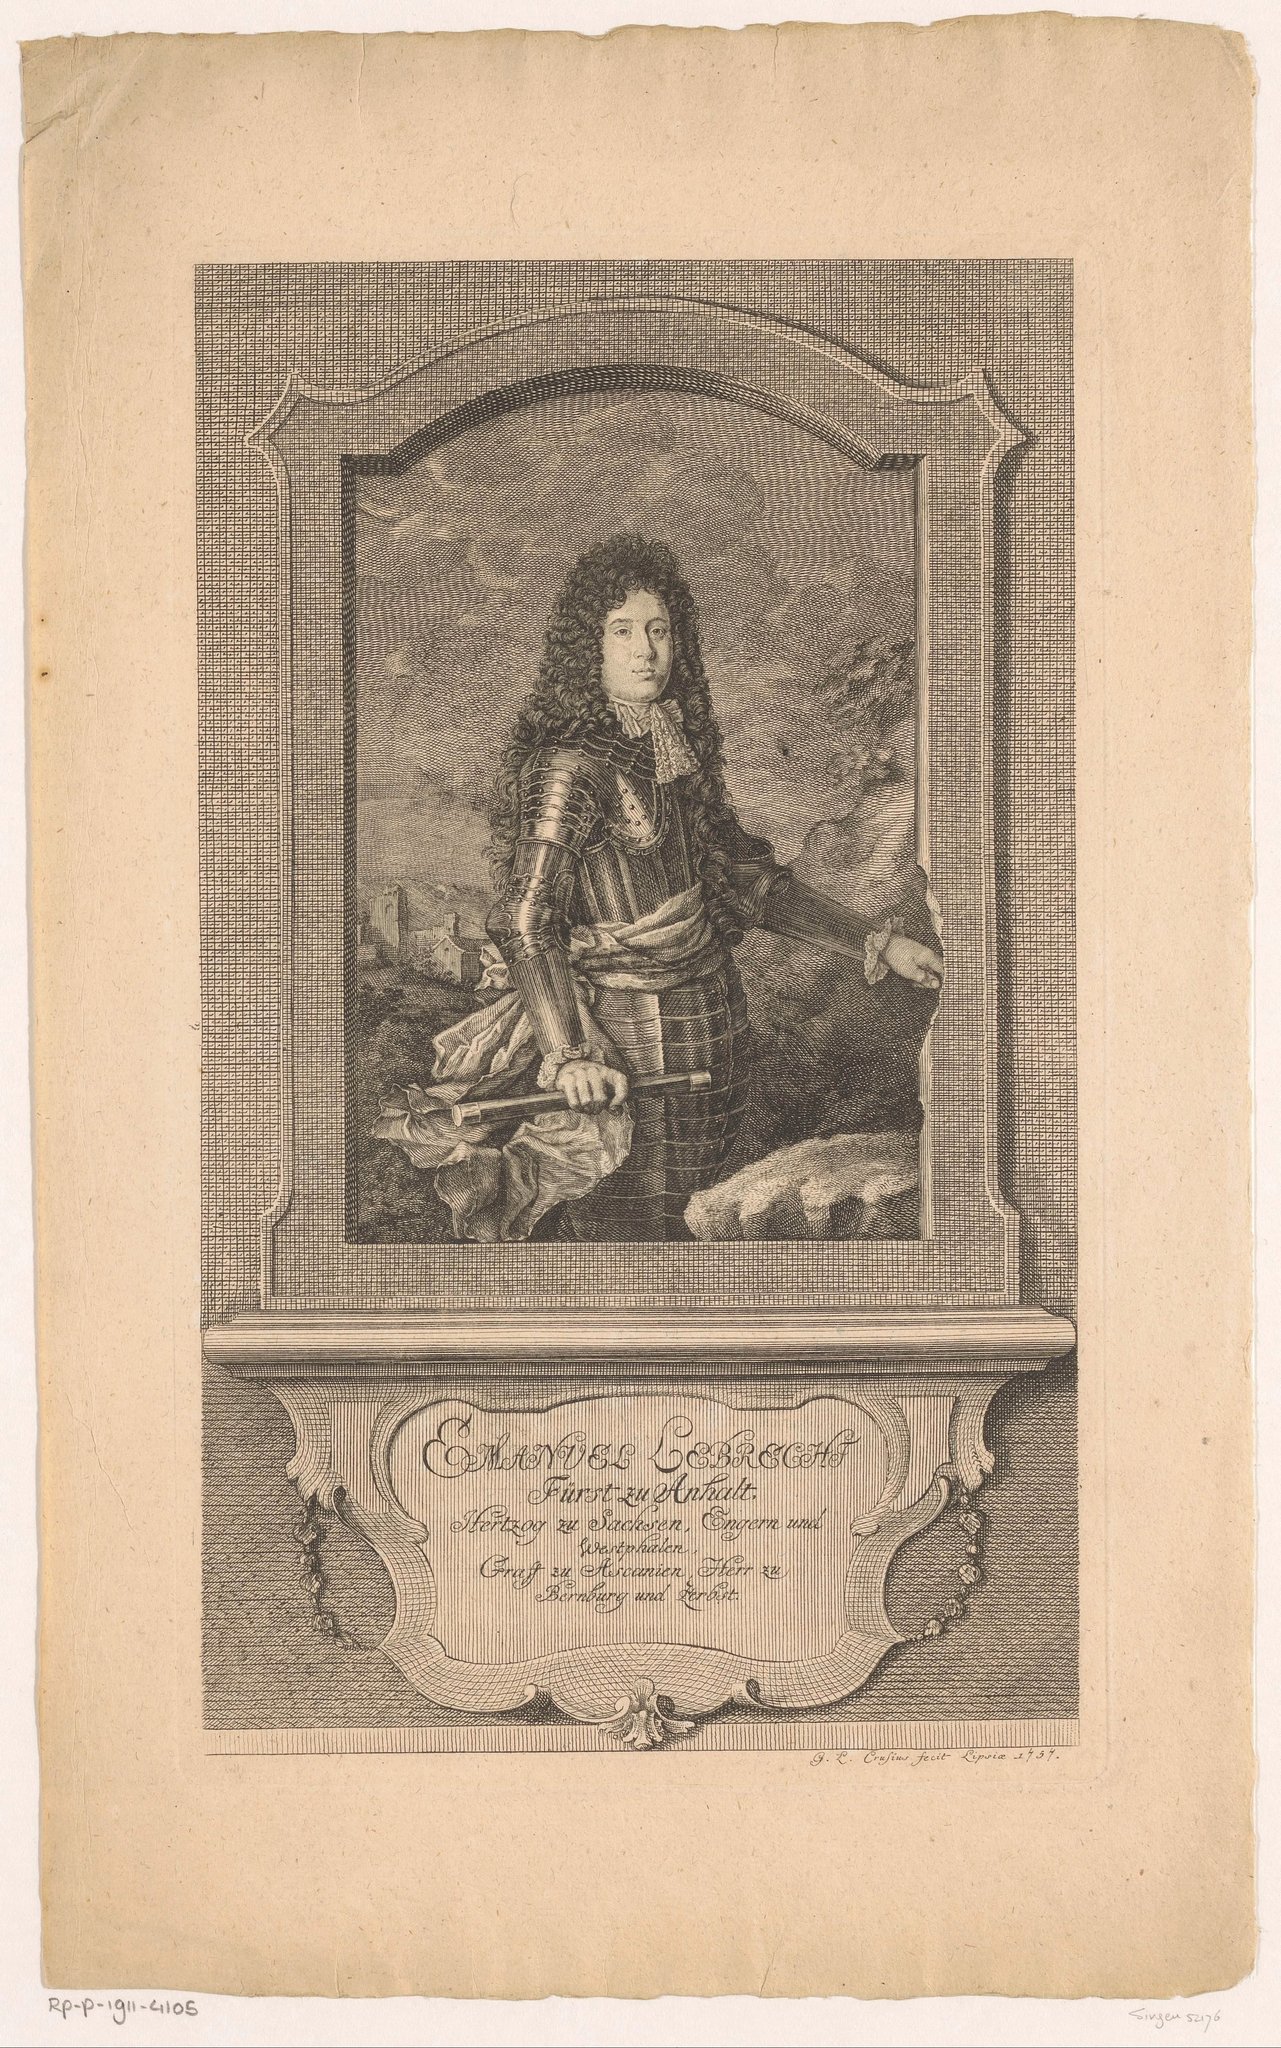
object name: print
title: Portret van Emanuel Lebrecht von Anhalt-Köthen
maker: gottlieb leberecht crusius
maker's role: print maker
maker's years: 1730-1804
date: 1757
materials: paper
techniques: engraving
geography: leipzig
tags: historical persons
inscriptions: collector's mark: Lugt 2228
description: Tweede staat met toegevoegde vervaardigingsgegevens.